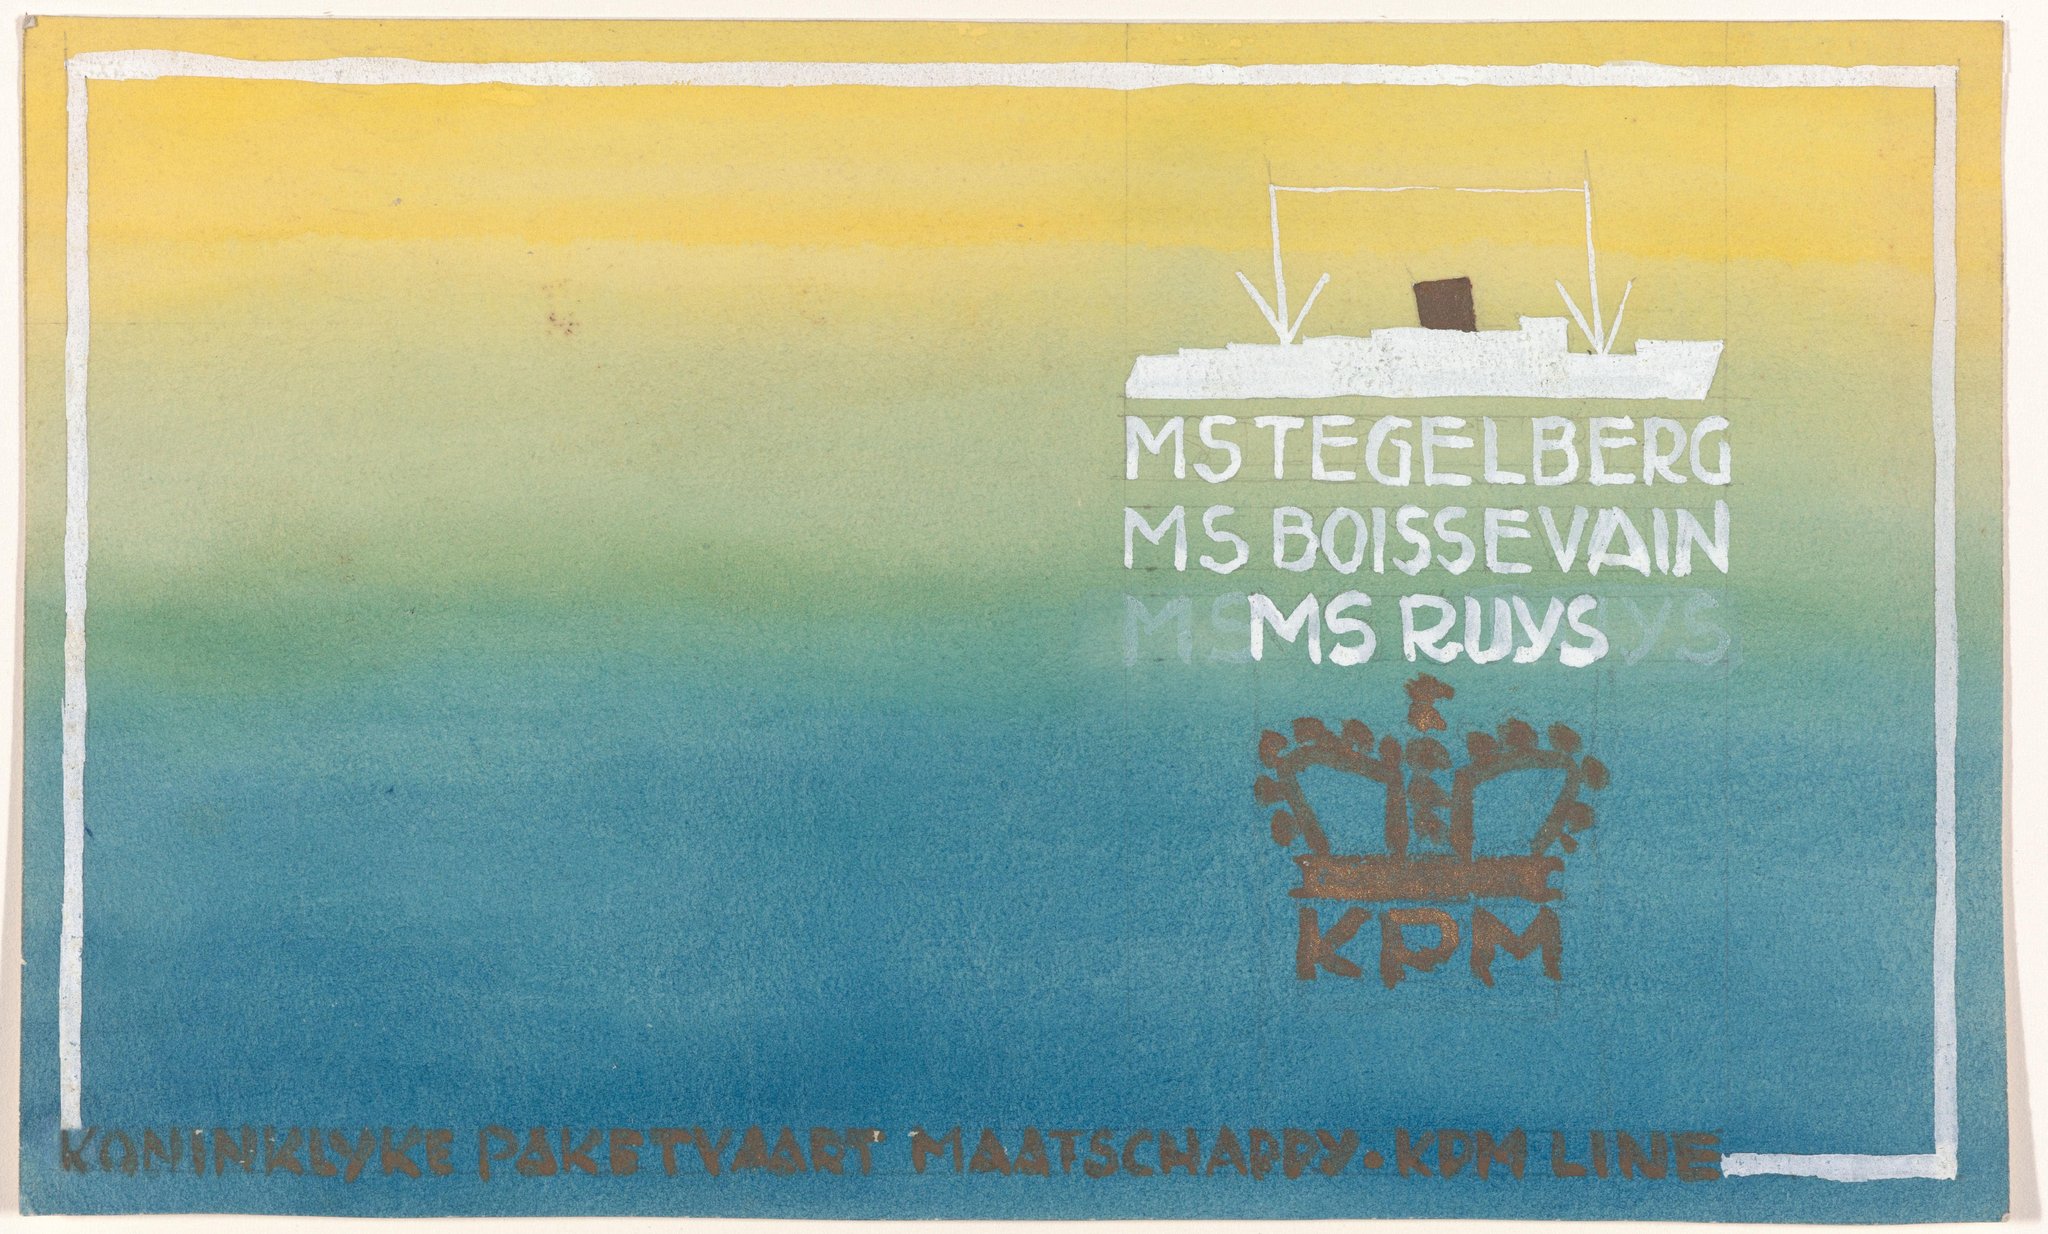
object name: drawing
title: Ontwerp voor vignet van de Koninklijke Paketvaart Maatschappij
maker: carel adolph lion cachet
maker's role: draughtsman, print maker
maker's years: 1864-1945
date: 1874-1945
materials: paper, pencil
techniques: brush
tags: frontispiece, names of organizations, companies, trade unions, etc., steamship, motorship